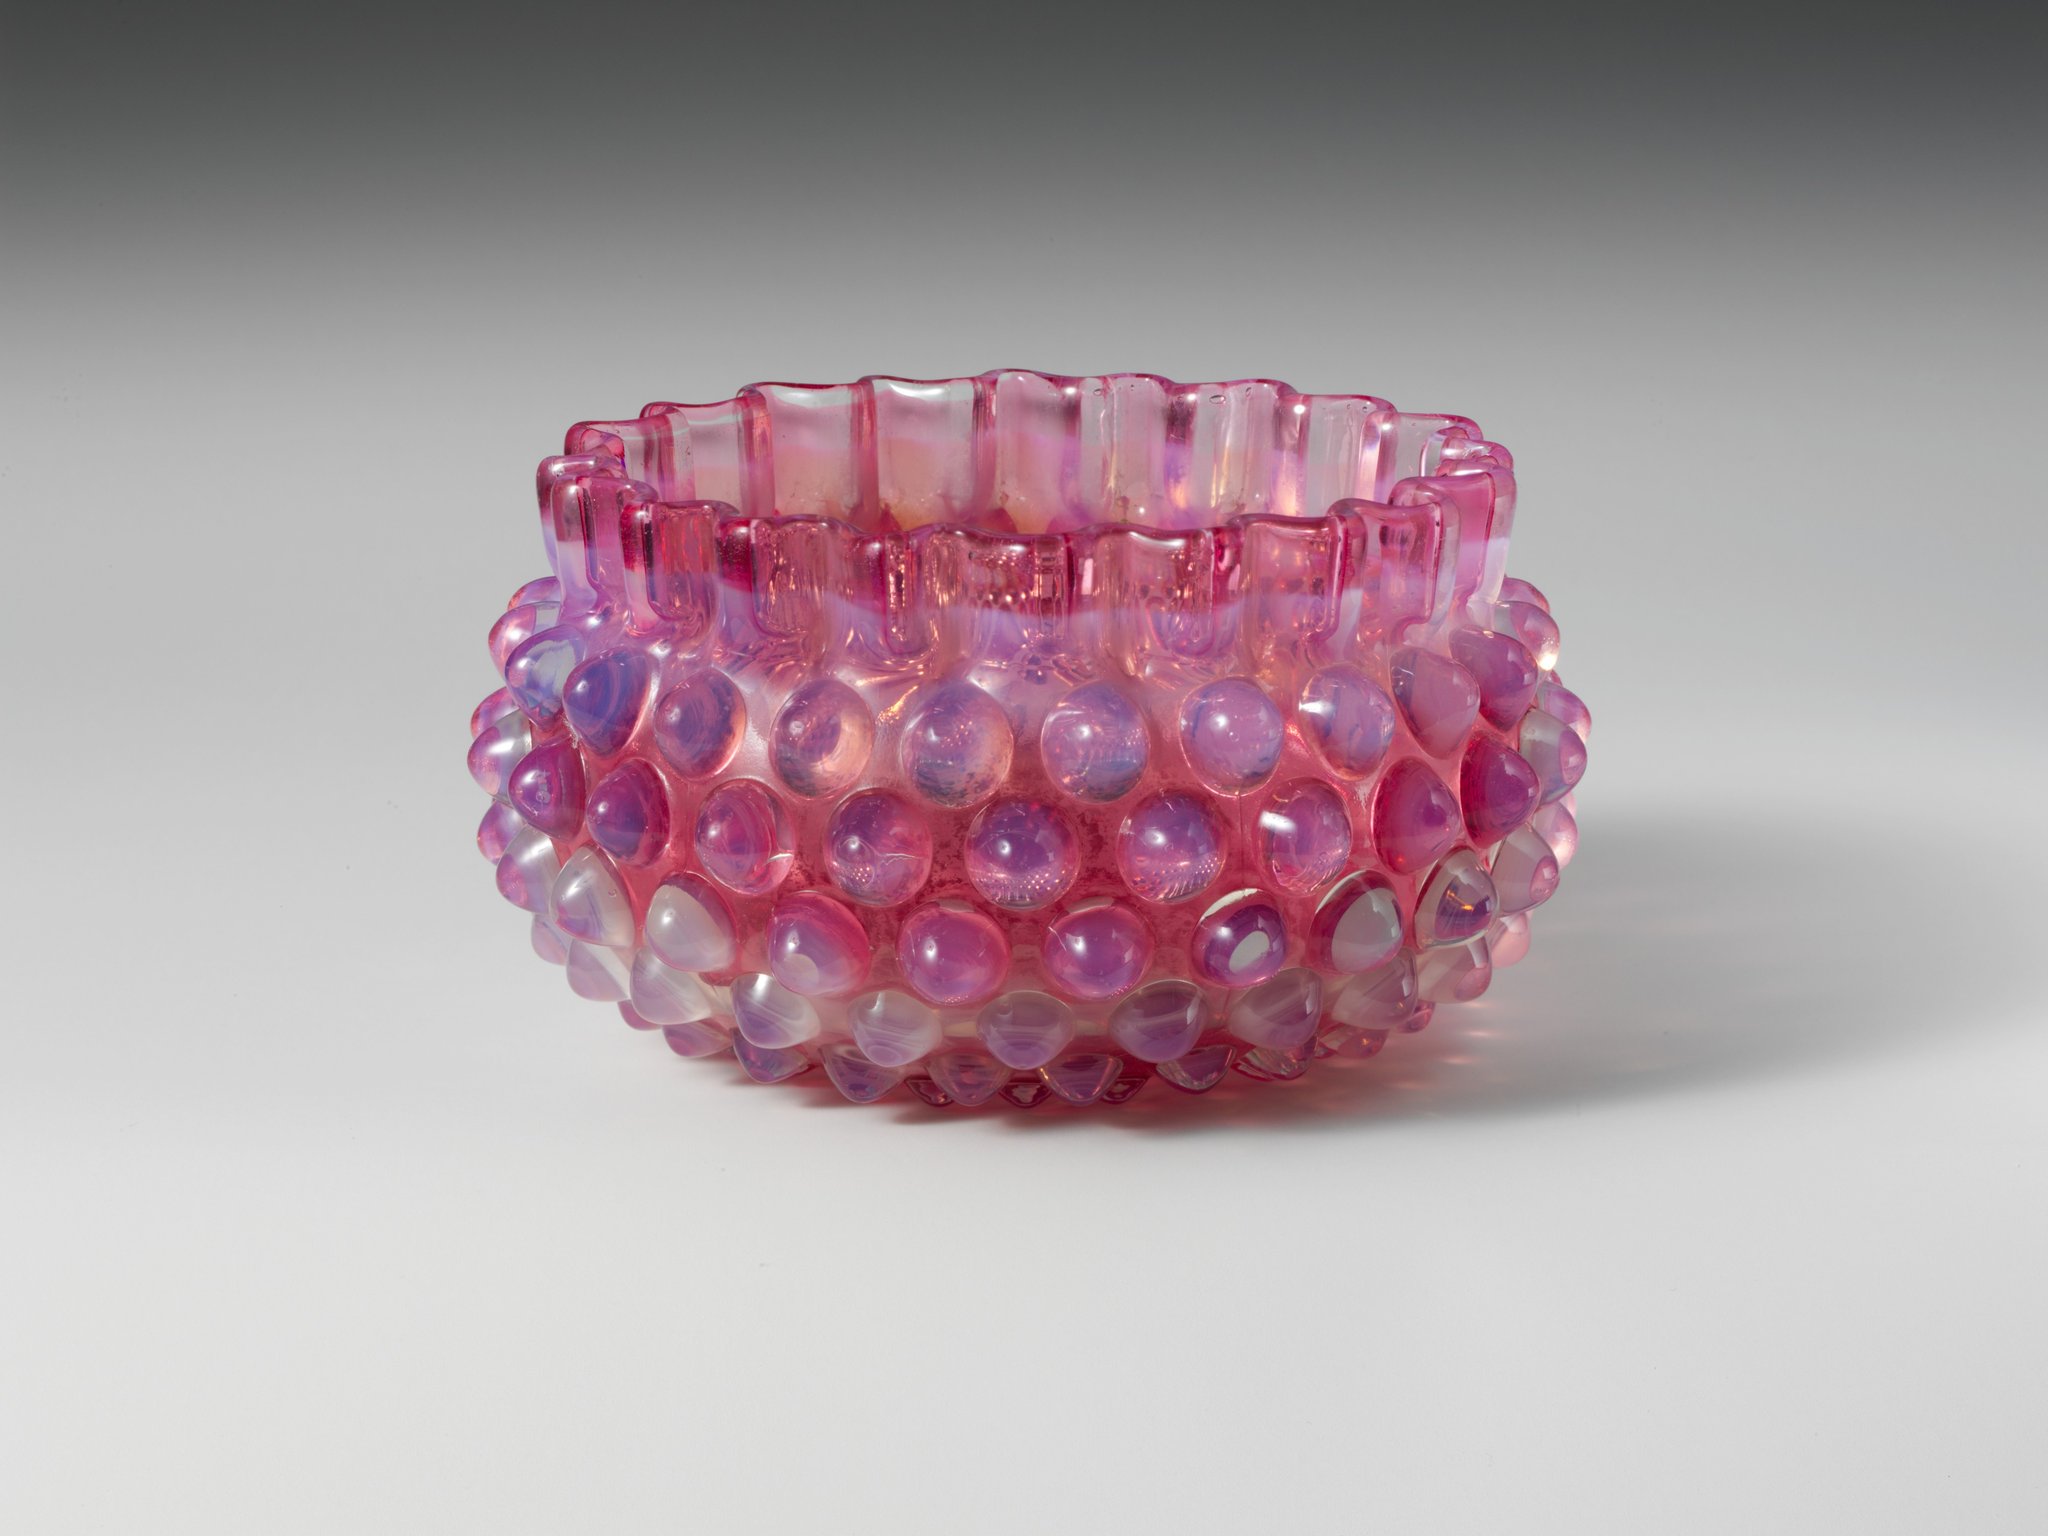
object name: finger bowl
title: Hobnail Finger Bowl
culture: american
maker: hobbs, brockunier and company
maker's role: maker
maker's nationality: american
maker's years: 1863-1891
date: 1886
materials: glass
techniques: pressed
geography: united states